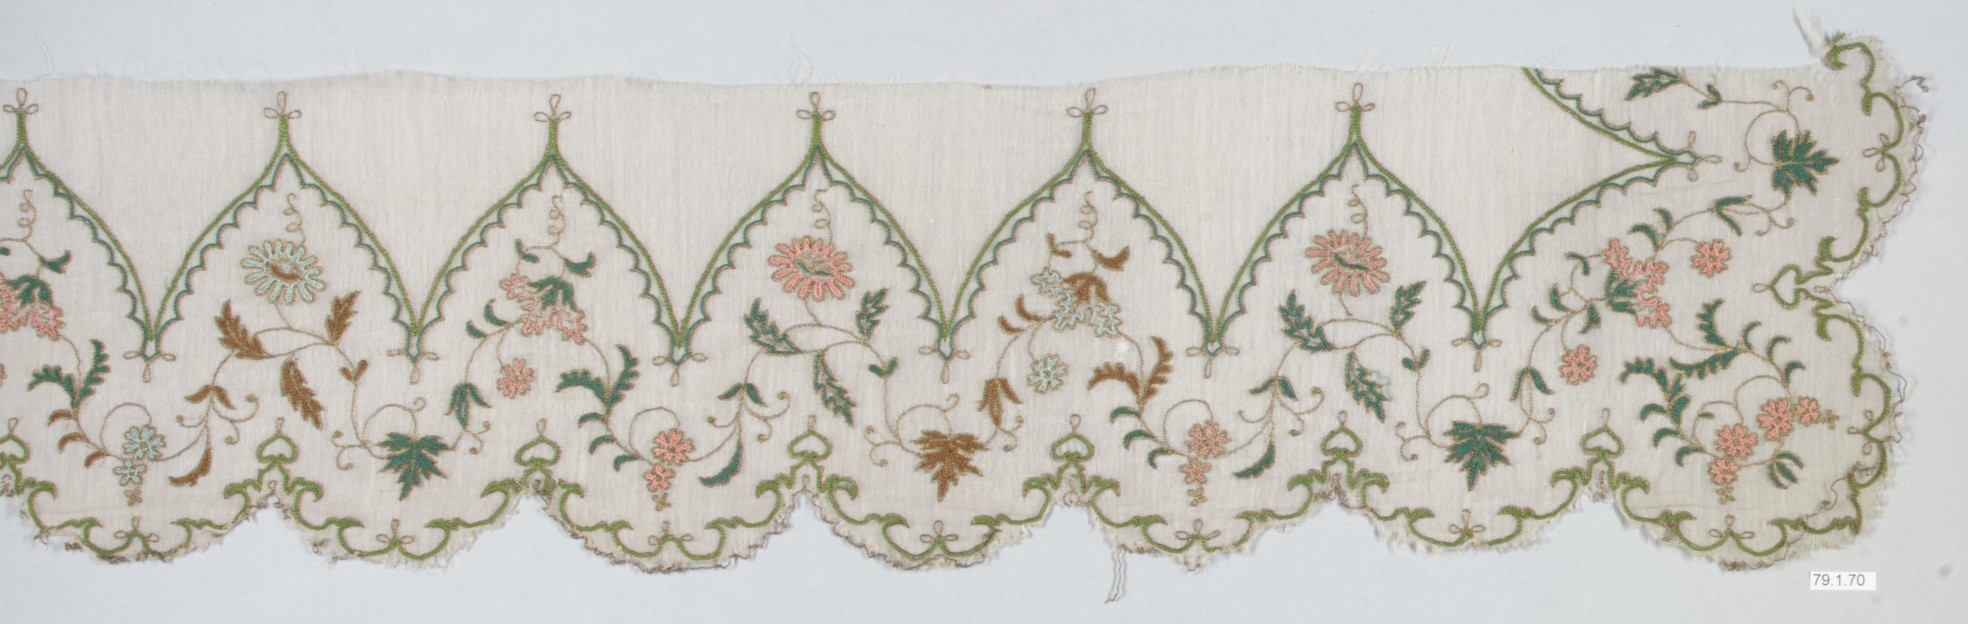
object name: textile fragment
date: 1801-1833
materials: metal thread, silk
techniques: embroidery, weave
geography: turkey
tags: flowers